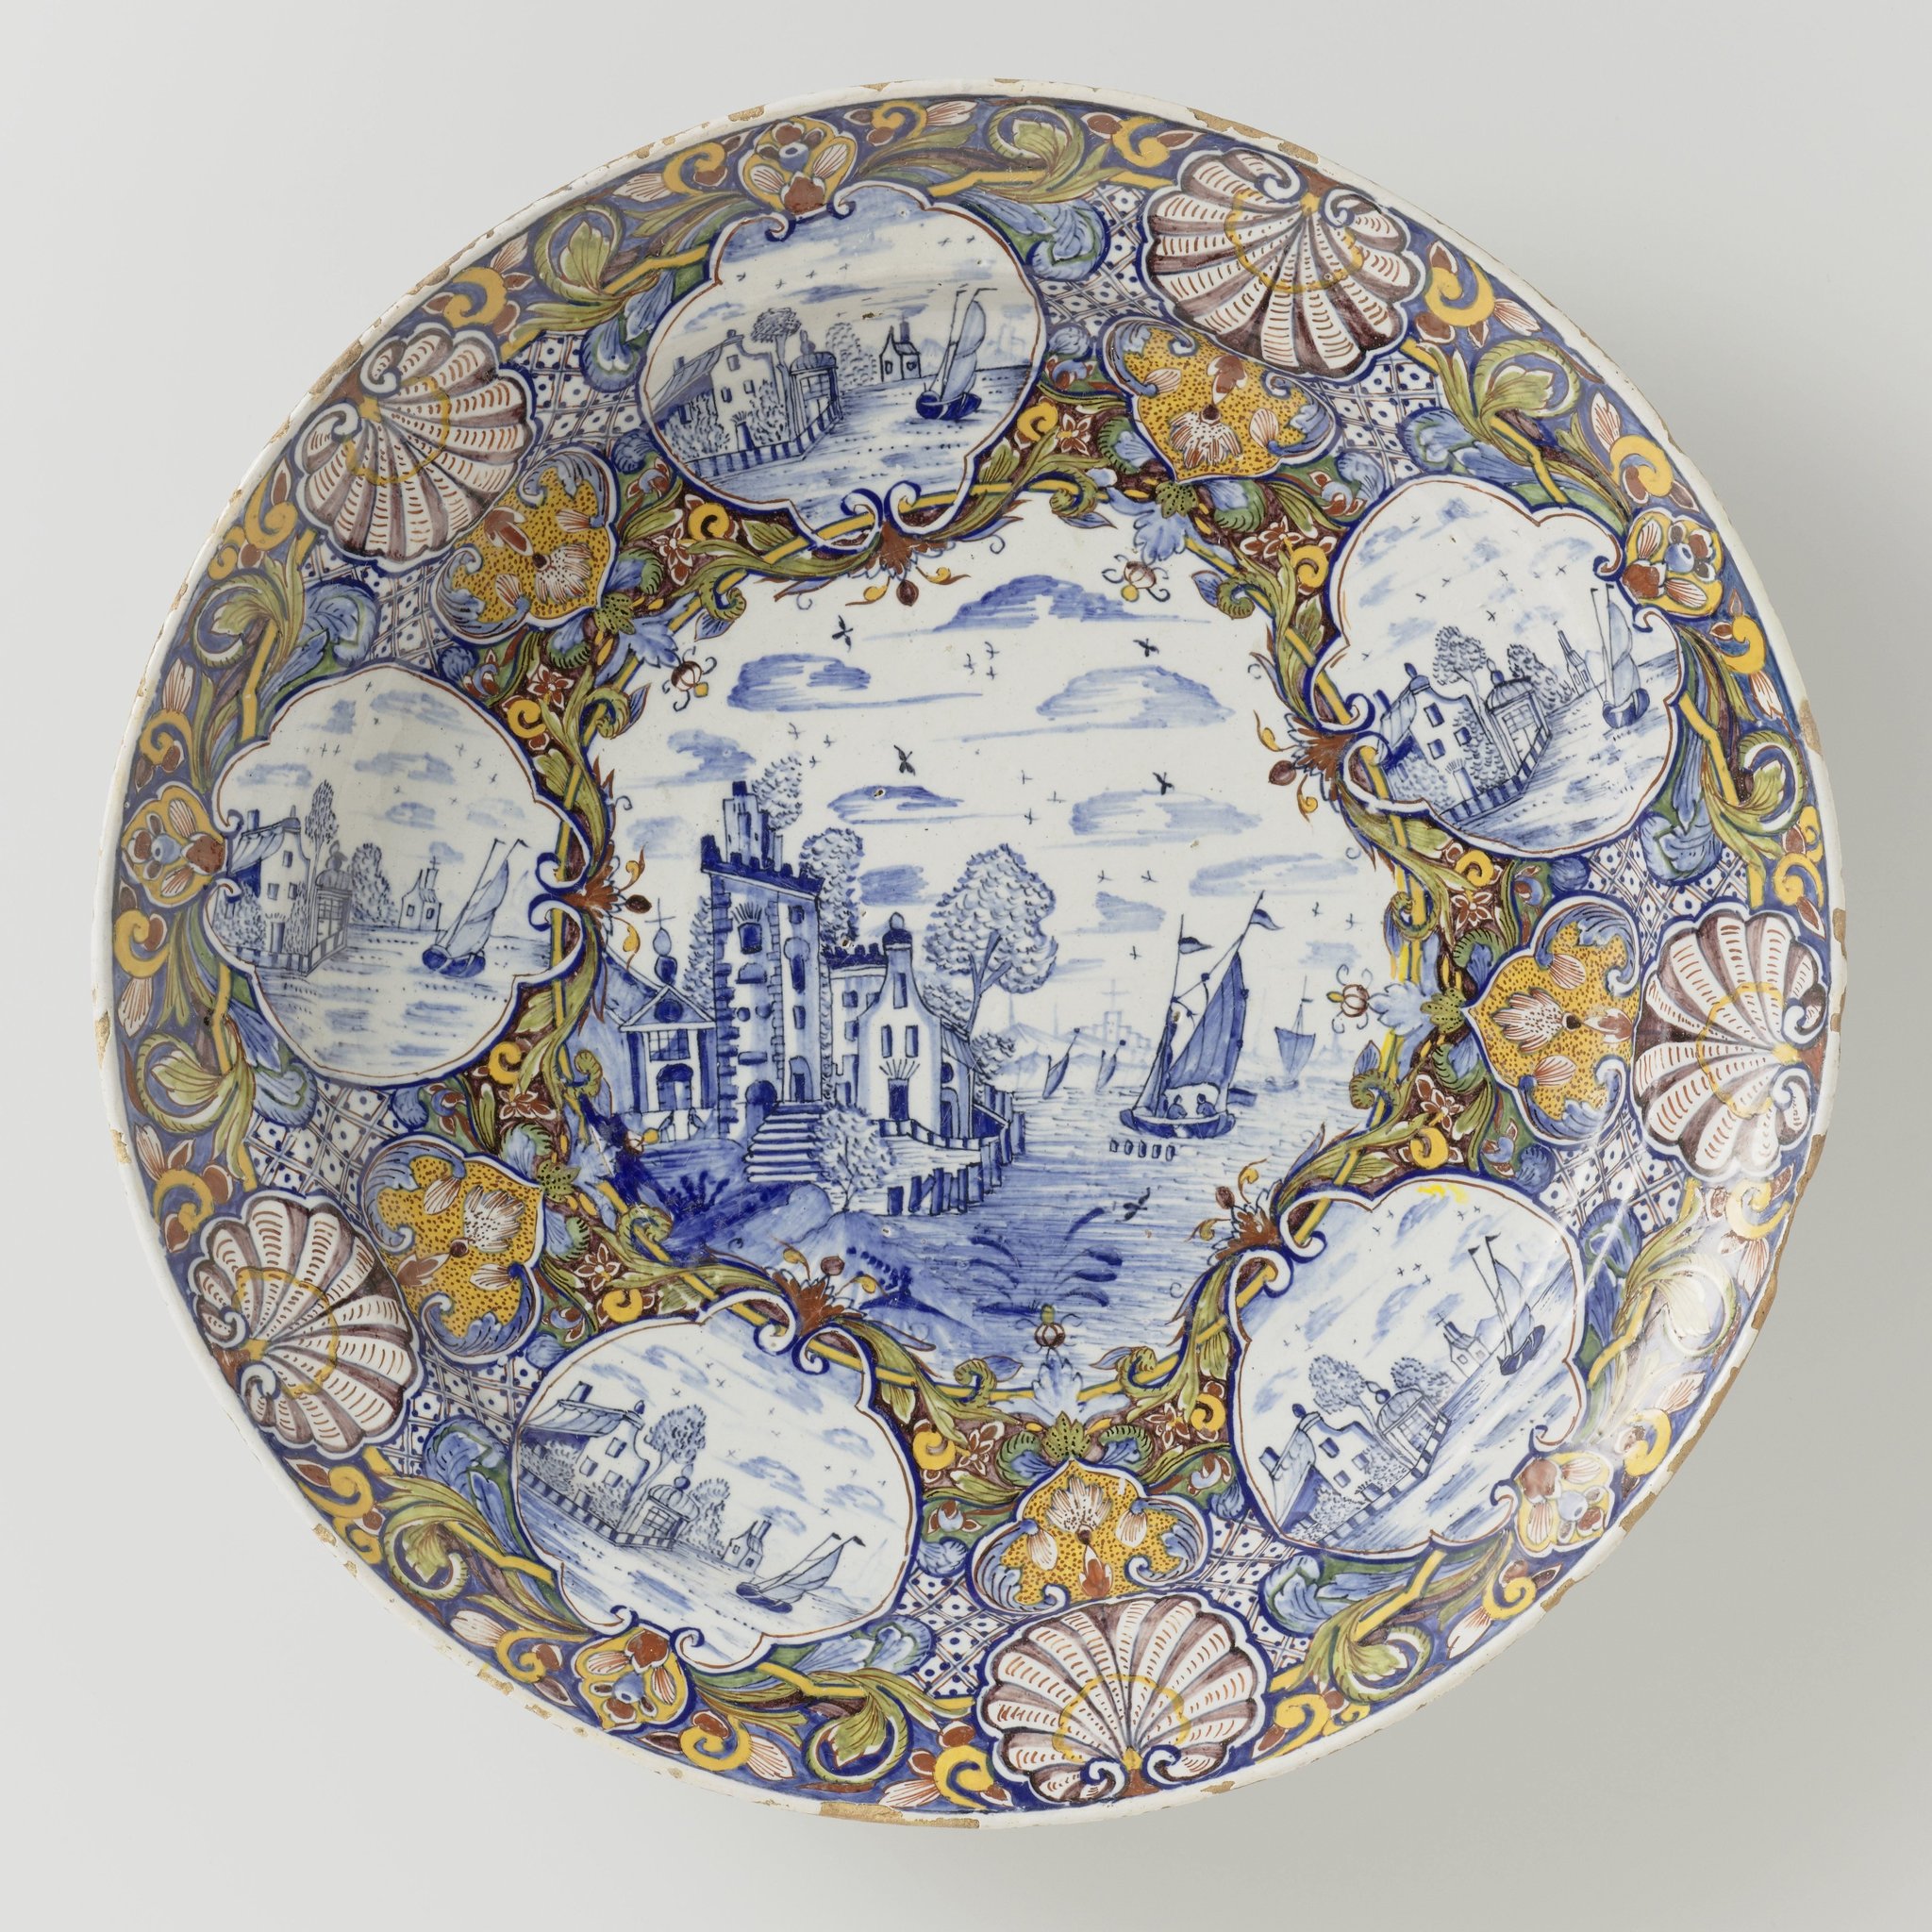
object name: platter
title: Schotel, beschilderd met waterlandschappen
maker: Anonymous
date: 1756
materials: faience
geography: delft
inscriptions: date: ‘1756’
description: Schotel van faïence, veelkleurig beschilderd met waterlandschappen.